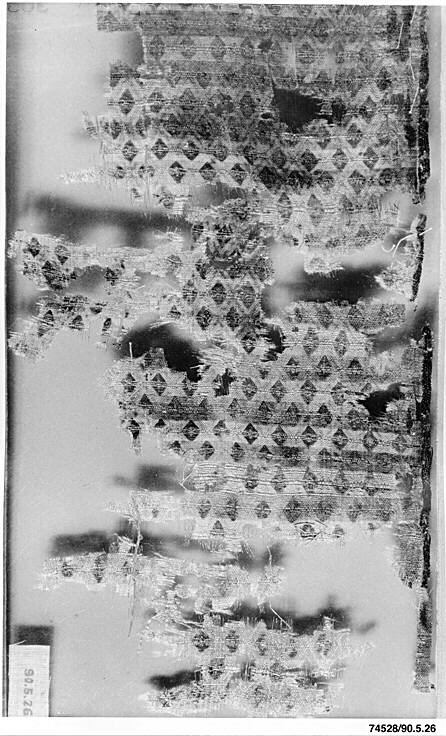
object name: textile fragment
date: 101-600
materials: silk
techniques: weave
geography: egypt